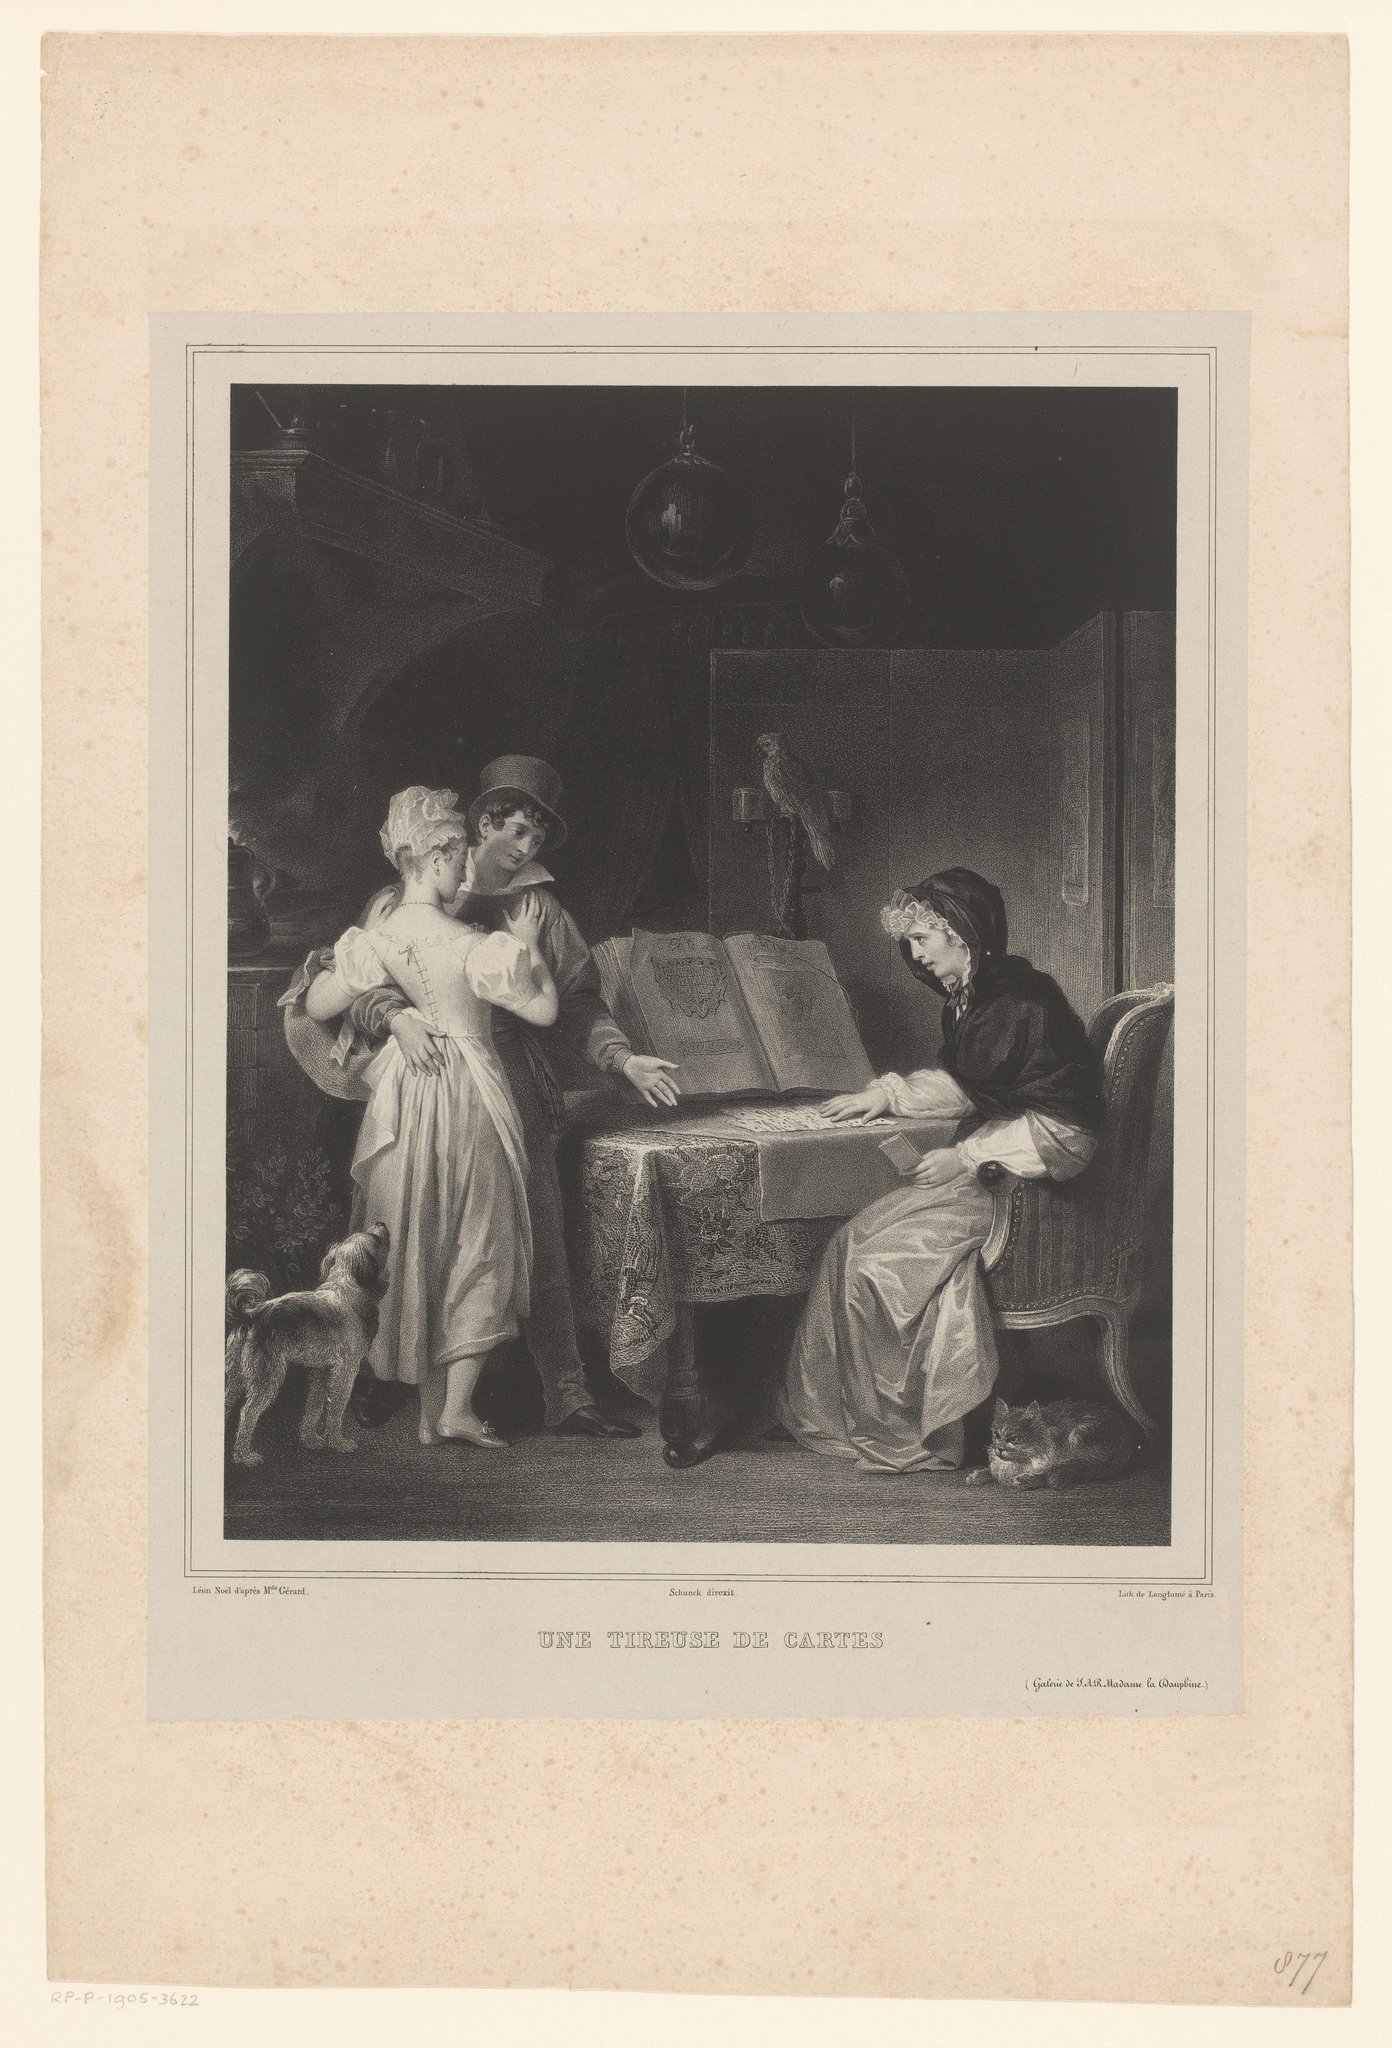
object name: print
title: Une tireuse de cartes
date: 1818-1861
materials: paper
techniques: lithograph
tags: ornamental birds: parrot, fortune-teller ~ pleasure fair and circus, playing-cards, couple of lovers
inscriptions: check stamp: ‘Lerendu editeur’, collector's mark: Lugt 2228